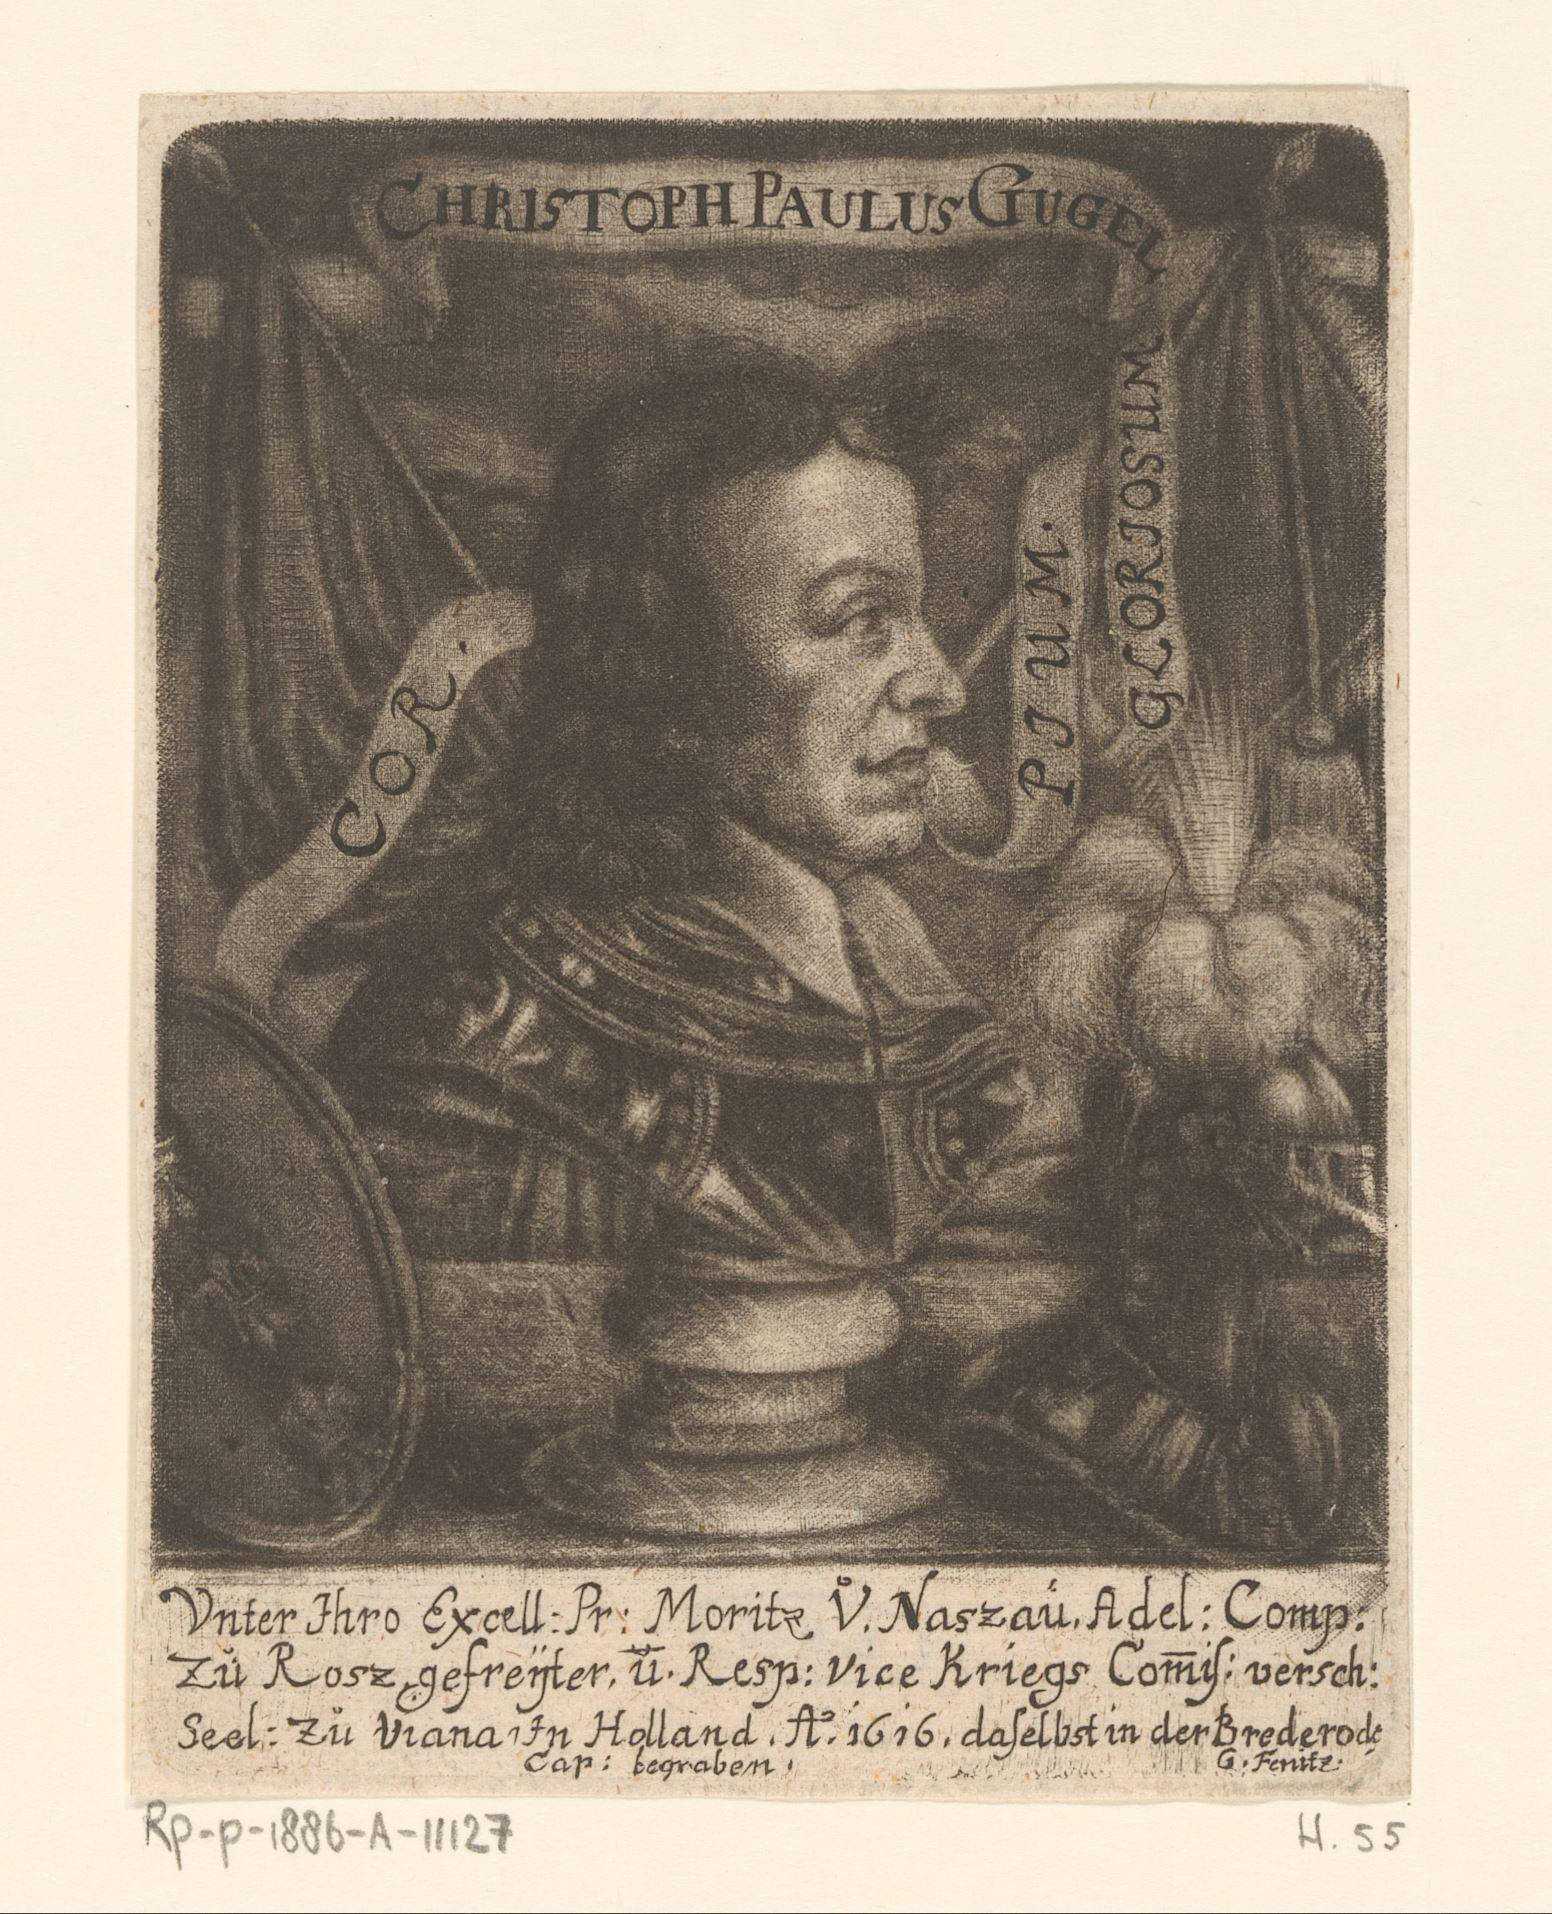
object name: print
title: Portretbuste van Christoph Paul Gugel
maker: georg fennitzer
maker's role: print maker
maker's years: 1646-1722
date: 1656-1722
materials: paper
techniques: mezzotint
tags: chest, bust, historical persons, symbols, allegories of war; 'guerra' (ripa)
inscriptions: collector's mark: Lugt 2228